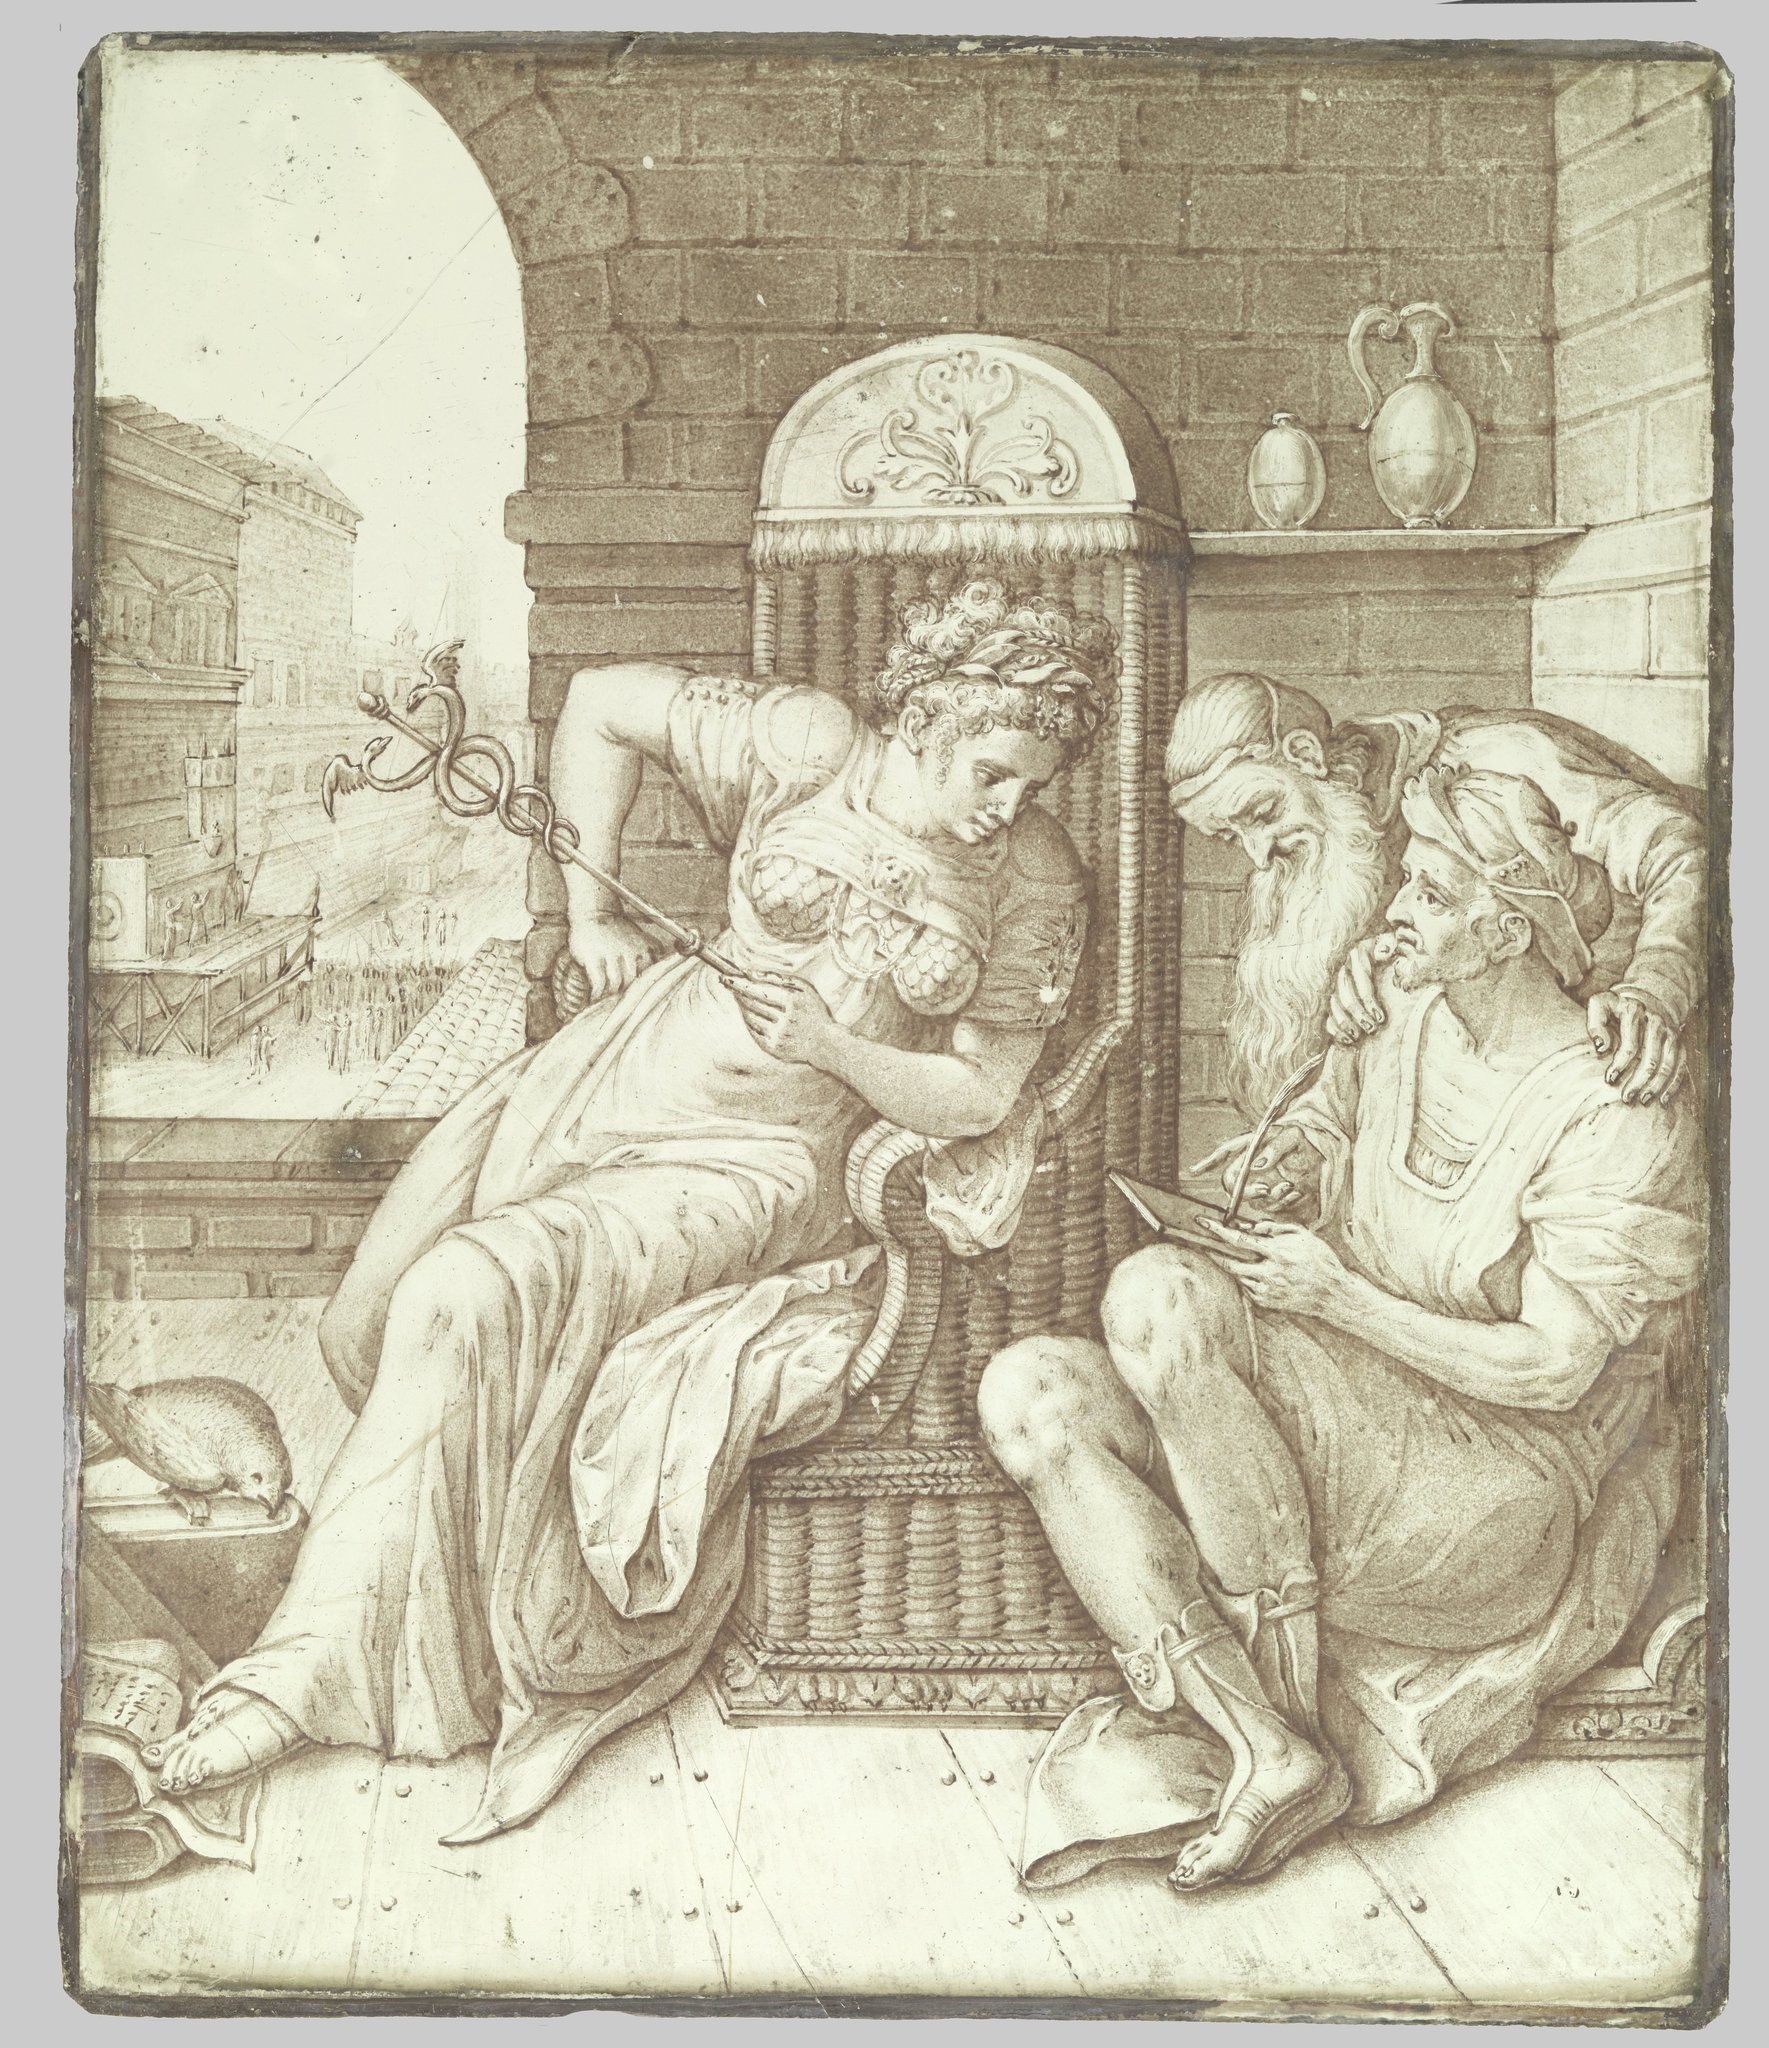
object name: light window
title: Rhetorica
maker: jacques de gheyn (i)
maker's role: draughtsman, print maker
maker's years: 1537-1581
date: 1565-1582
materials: glass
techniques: enamel painting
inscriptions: signature: ‘IACOB de GHeYn’, monogram: ‘IvdG’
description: Rechthoekige monochrome glas-in-lood ruit met allegorische voorstelling van Rhetorica, een van de vrije kunsten. Zij wordt hier voorgesteld als een jonge vrouw die in een loomstoel zit en naar een toespraak van een jonge man luistert. De ruit is gevat in een 19de-eeuwse glas-omlijsting. Deze omlijsting toont in de vier hoeken mannenhoofden.